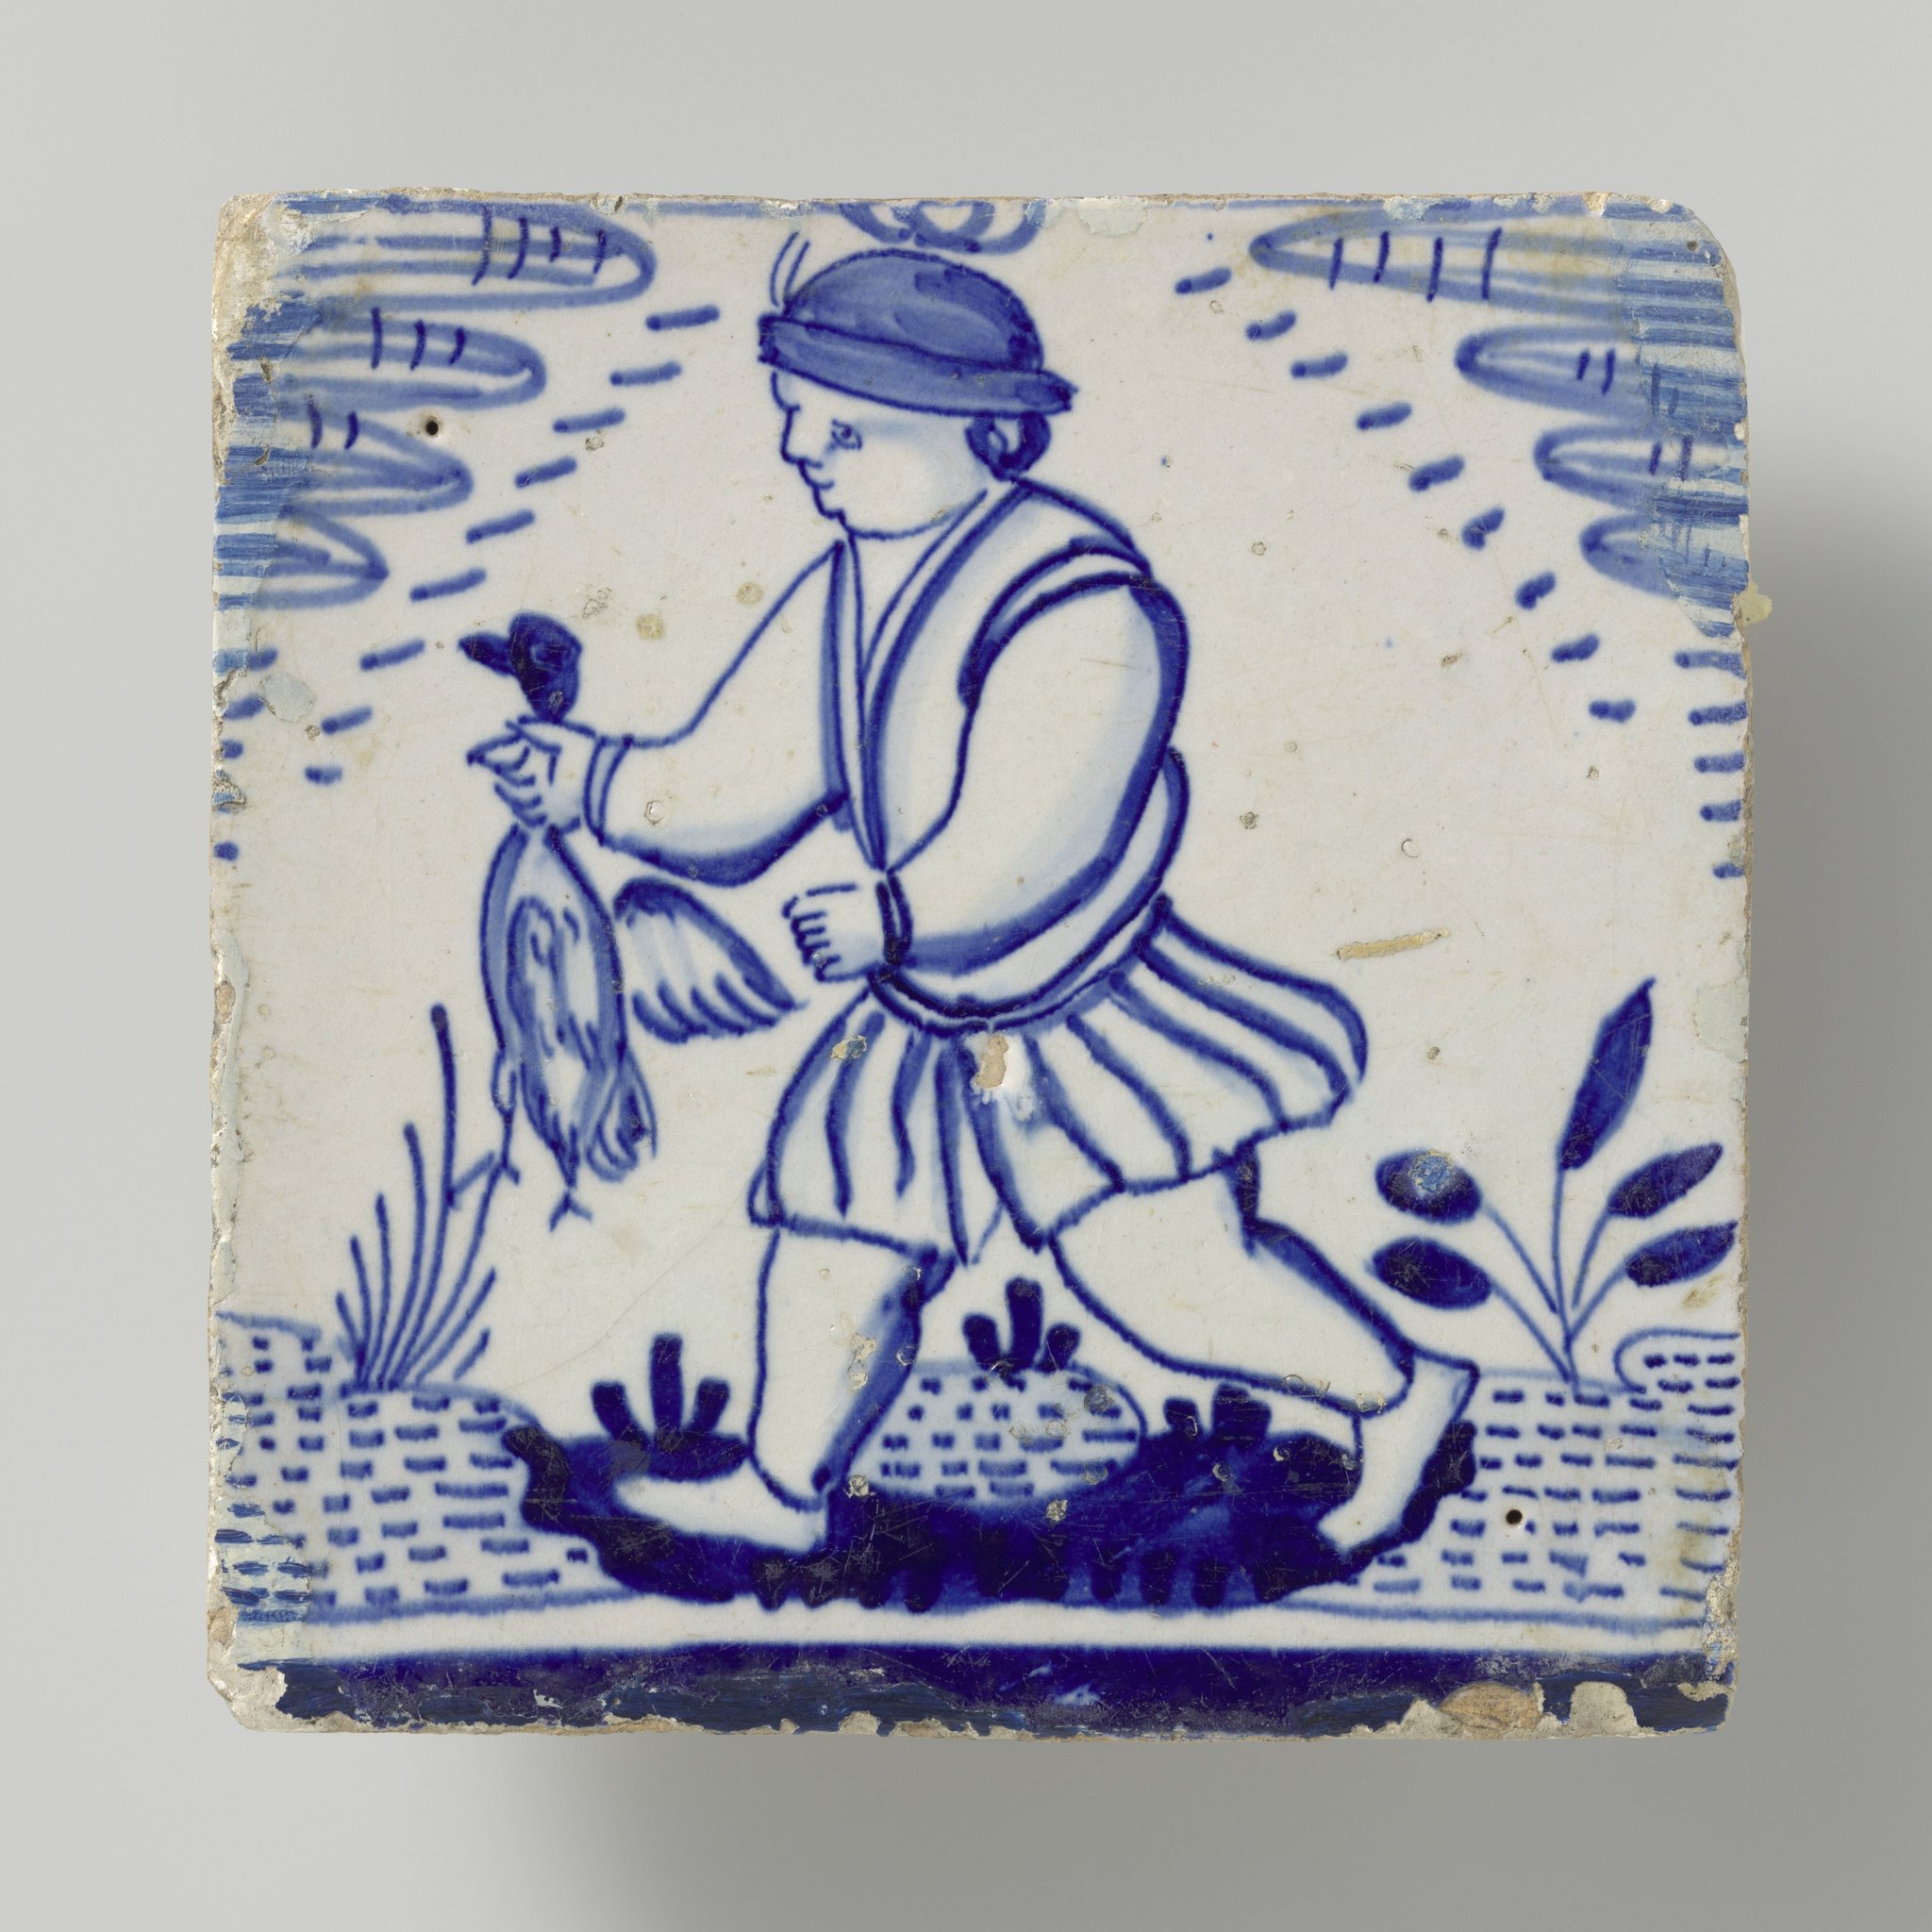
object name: tile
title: Tegel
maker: Anonymous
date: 1620-1640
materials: earthenware, glaze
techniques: maiolica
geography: rotterdam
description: Tegel met een blauwe geschilderde lopende jongen met muts en een gans in zijn rechter hand, op een grondje. De bovenhoeken zijn versierd met wolkenmotieven.